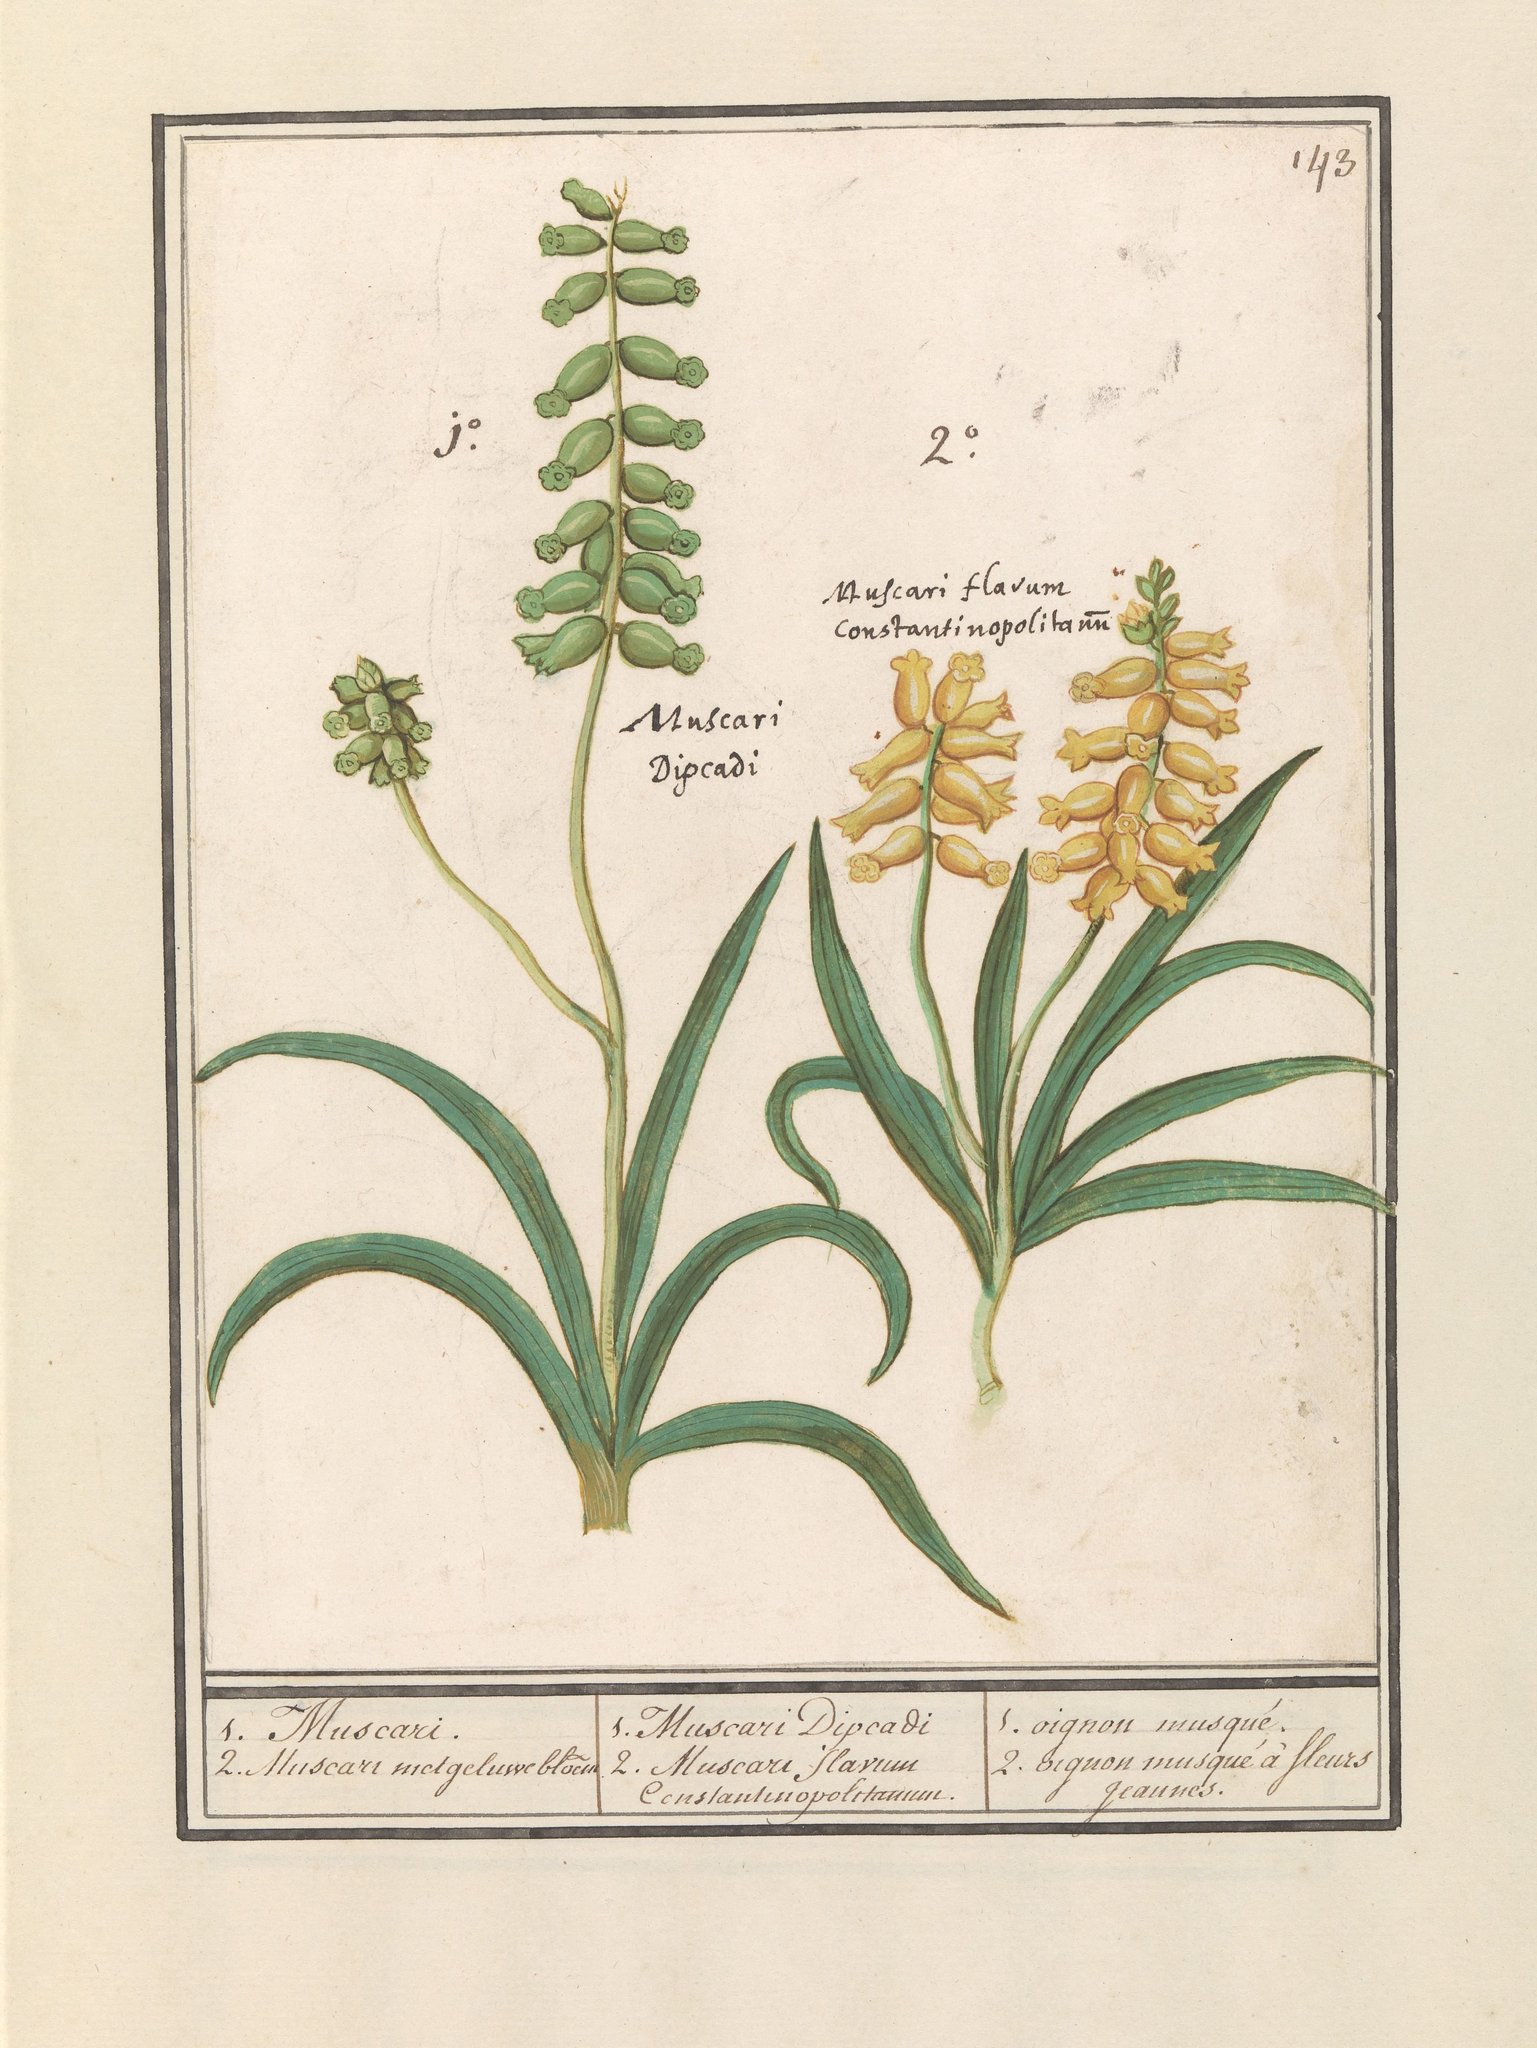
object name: drawing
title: 1. Muscari. 2. Muscari met geluwe bloem / 1. Muscari Dicadi 2. Muscari slavium Constantinopolitanium. / 1. oignon musqué. 2. oignon musqué à fleurs jeaunes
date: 1596-1610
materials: chalk, paint, ink, paper, watercolor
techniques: brush, pen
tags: flowers: grape hyacinth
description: Witte druifhyacinten. Rechtsboven genummerd: 143. Bij de bloemen de Latijnse namen. Onderdeel van het tweede album met tekeningen van bloemen en planten. Negende van twaalf albums met tekeningen van dieren, vogels en planten bekend rond 1600, gemaakt in opdracht van keizer Rudolf II. Met toelichting in Nederlands, Latijn en Frans.